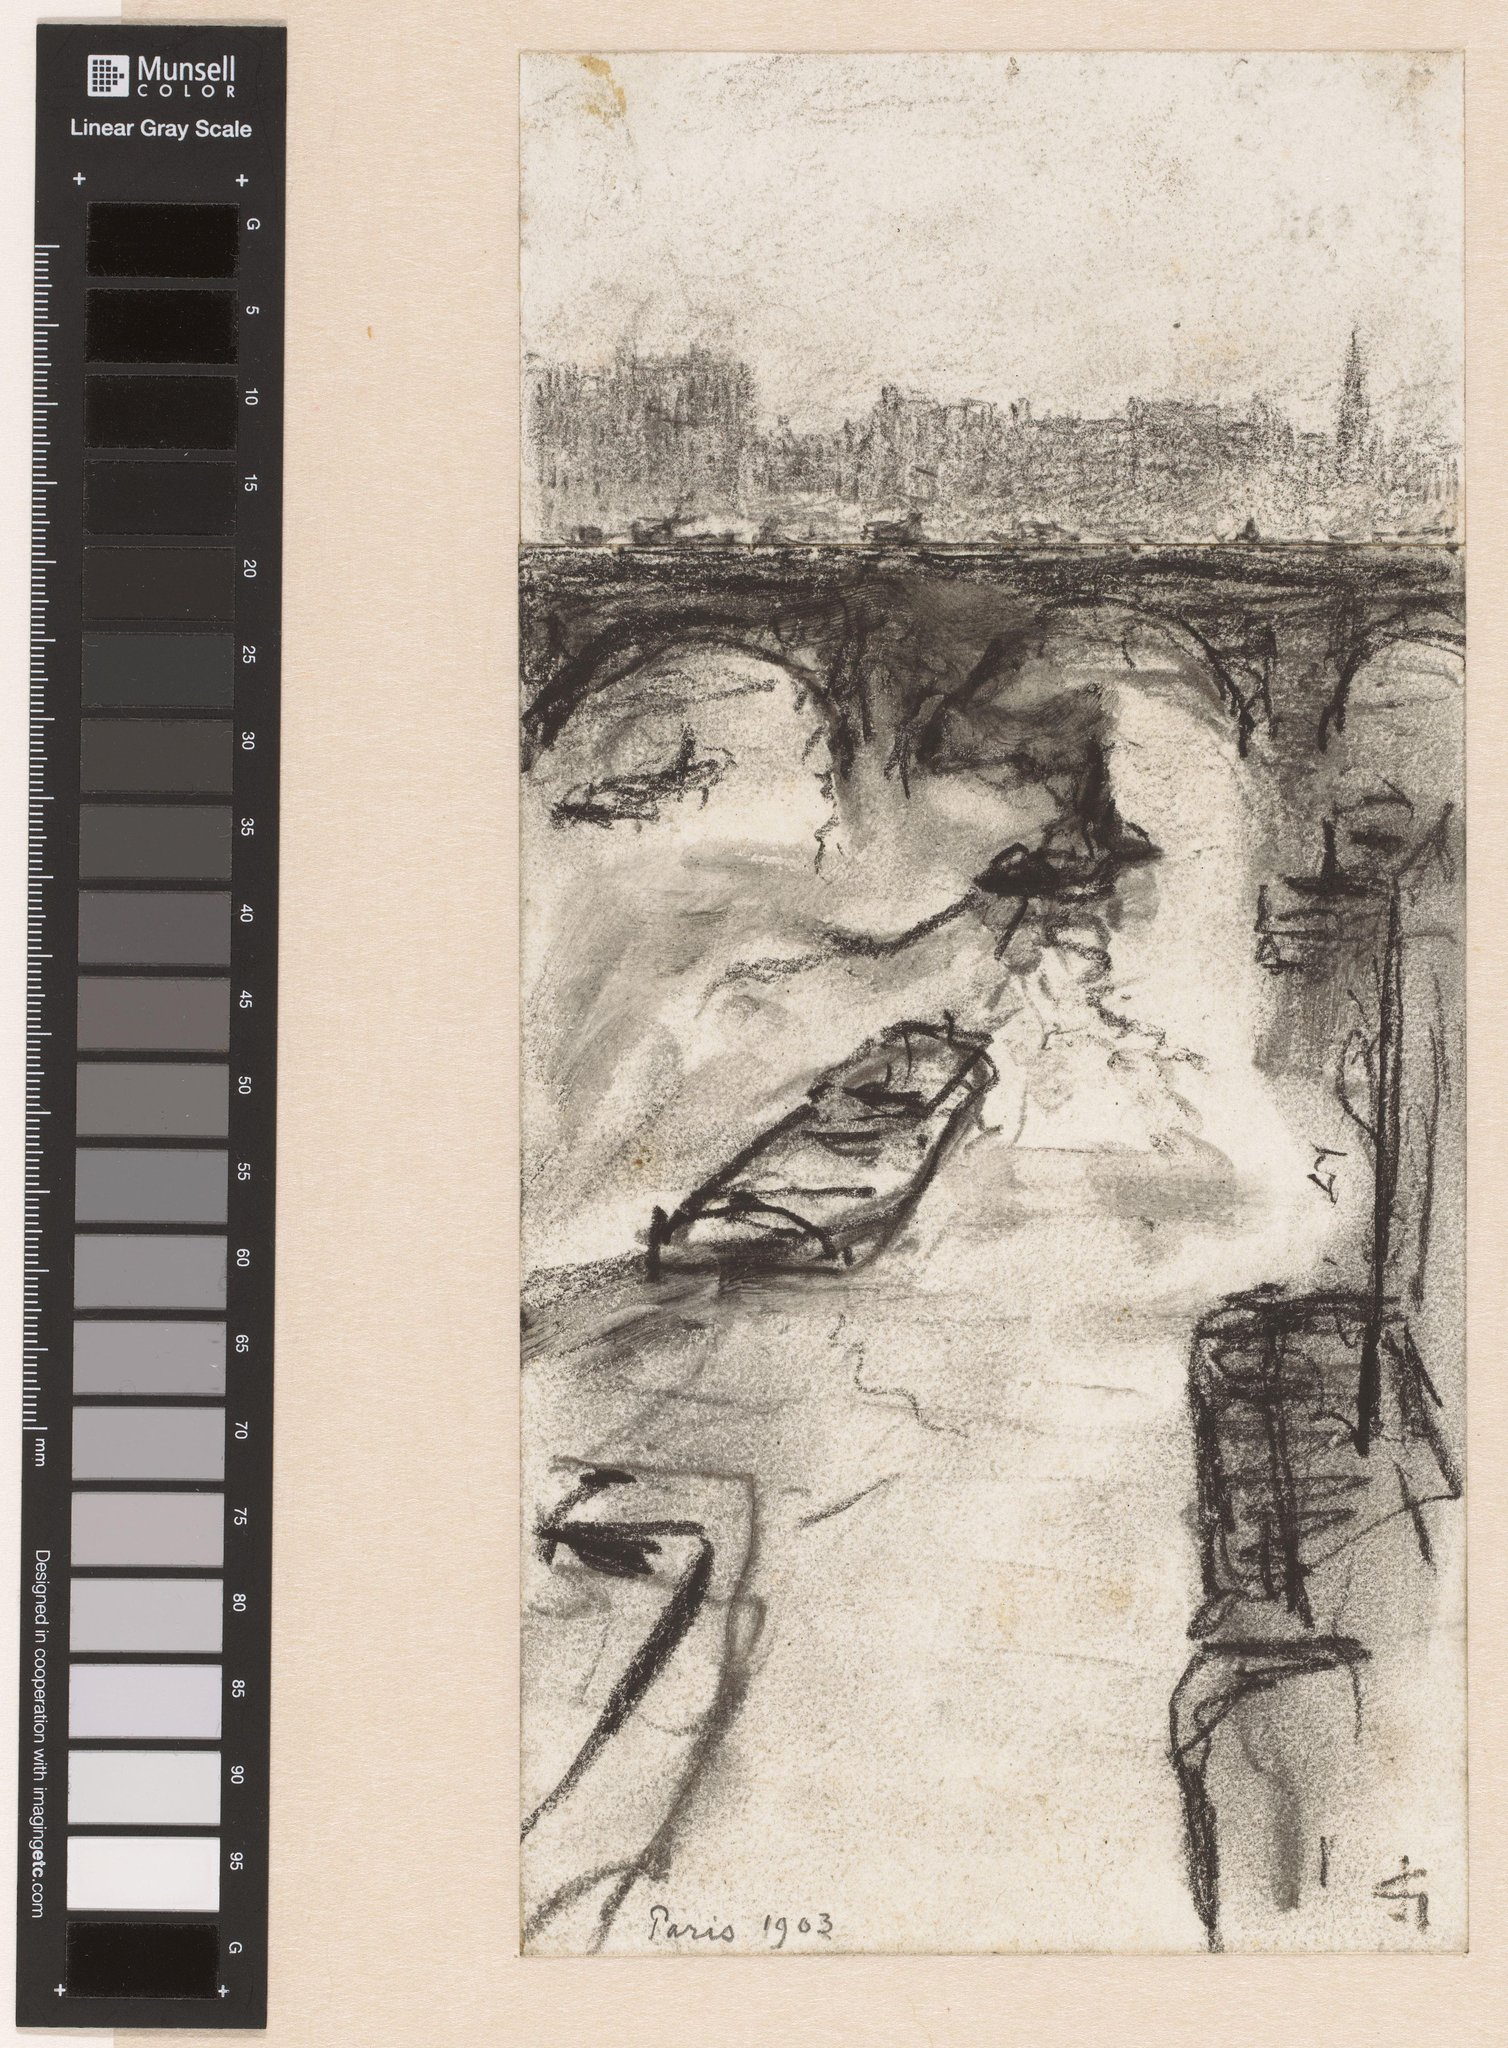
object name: drawing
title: Brug over de Seine, Parijs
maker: carel nicolaas storm van s-gravesande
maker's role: draughtsman, print maker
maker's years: 1841-1924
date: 1903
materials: chalk, paper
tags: bridge in city across river, canal, etc., paris